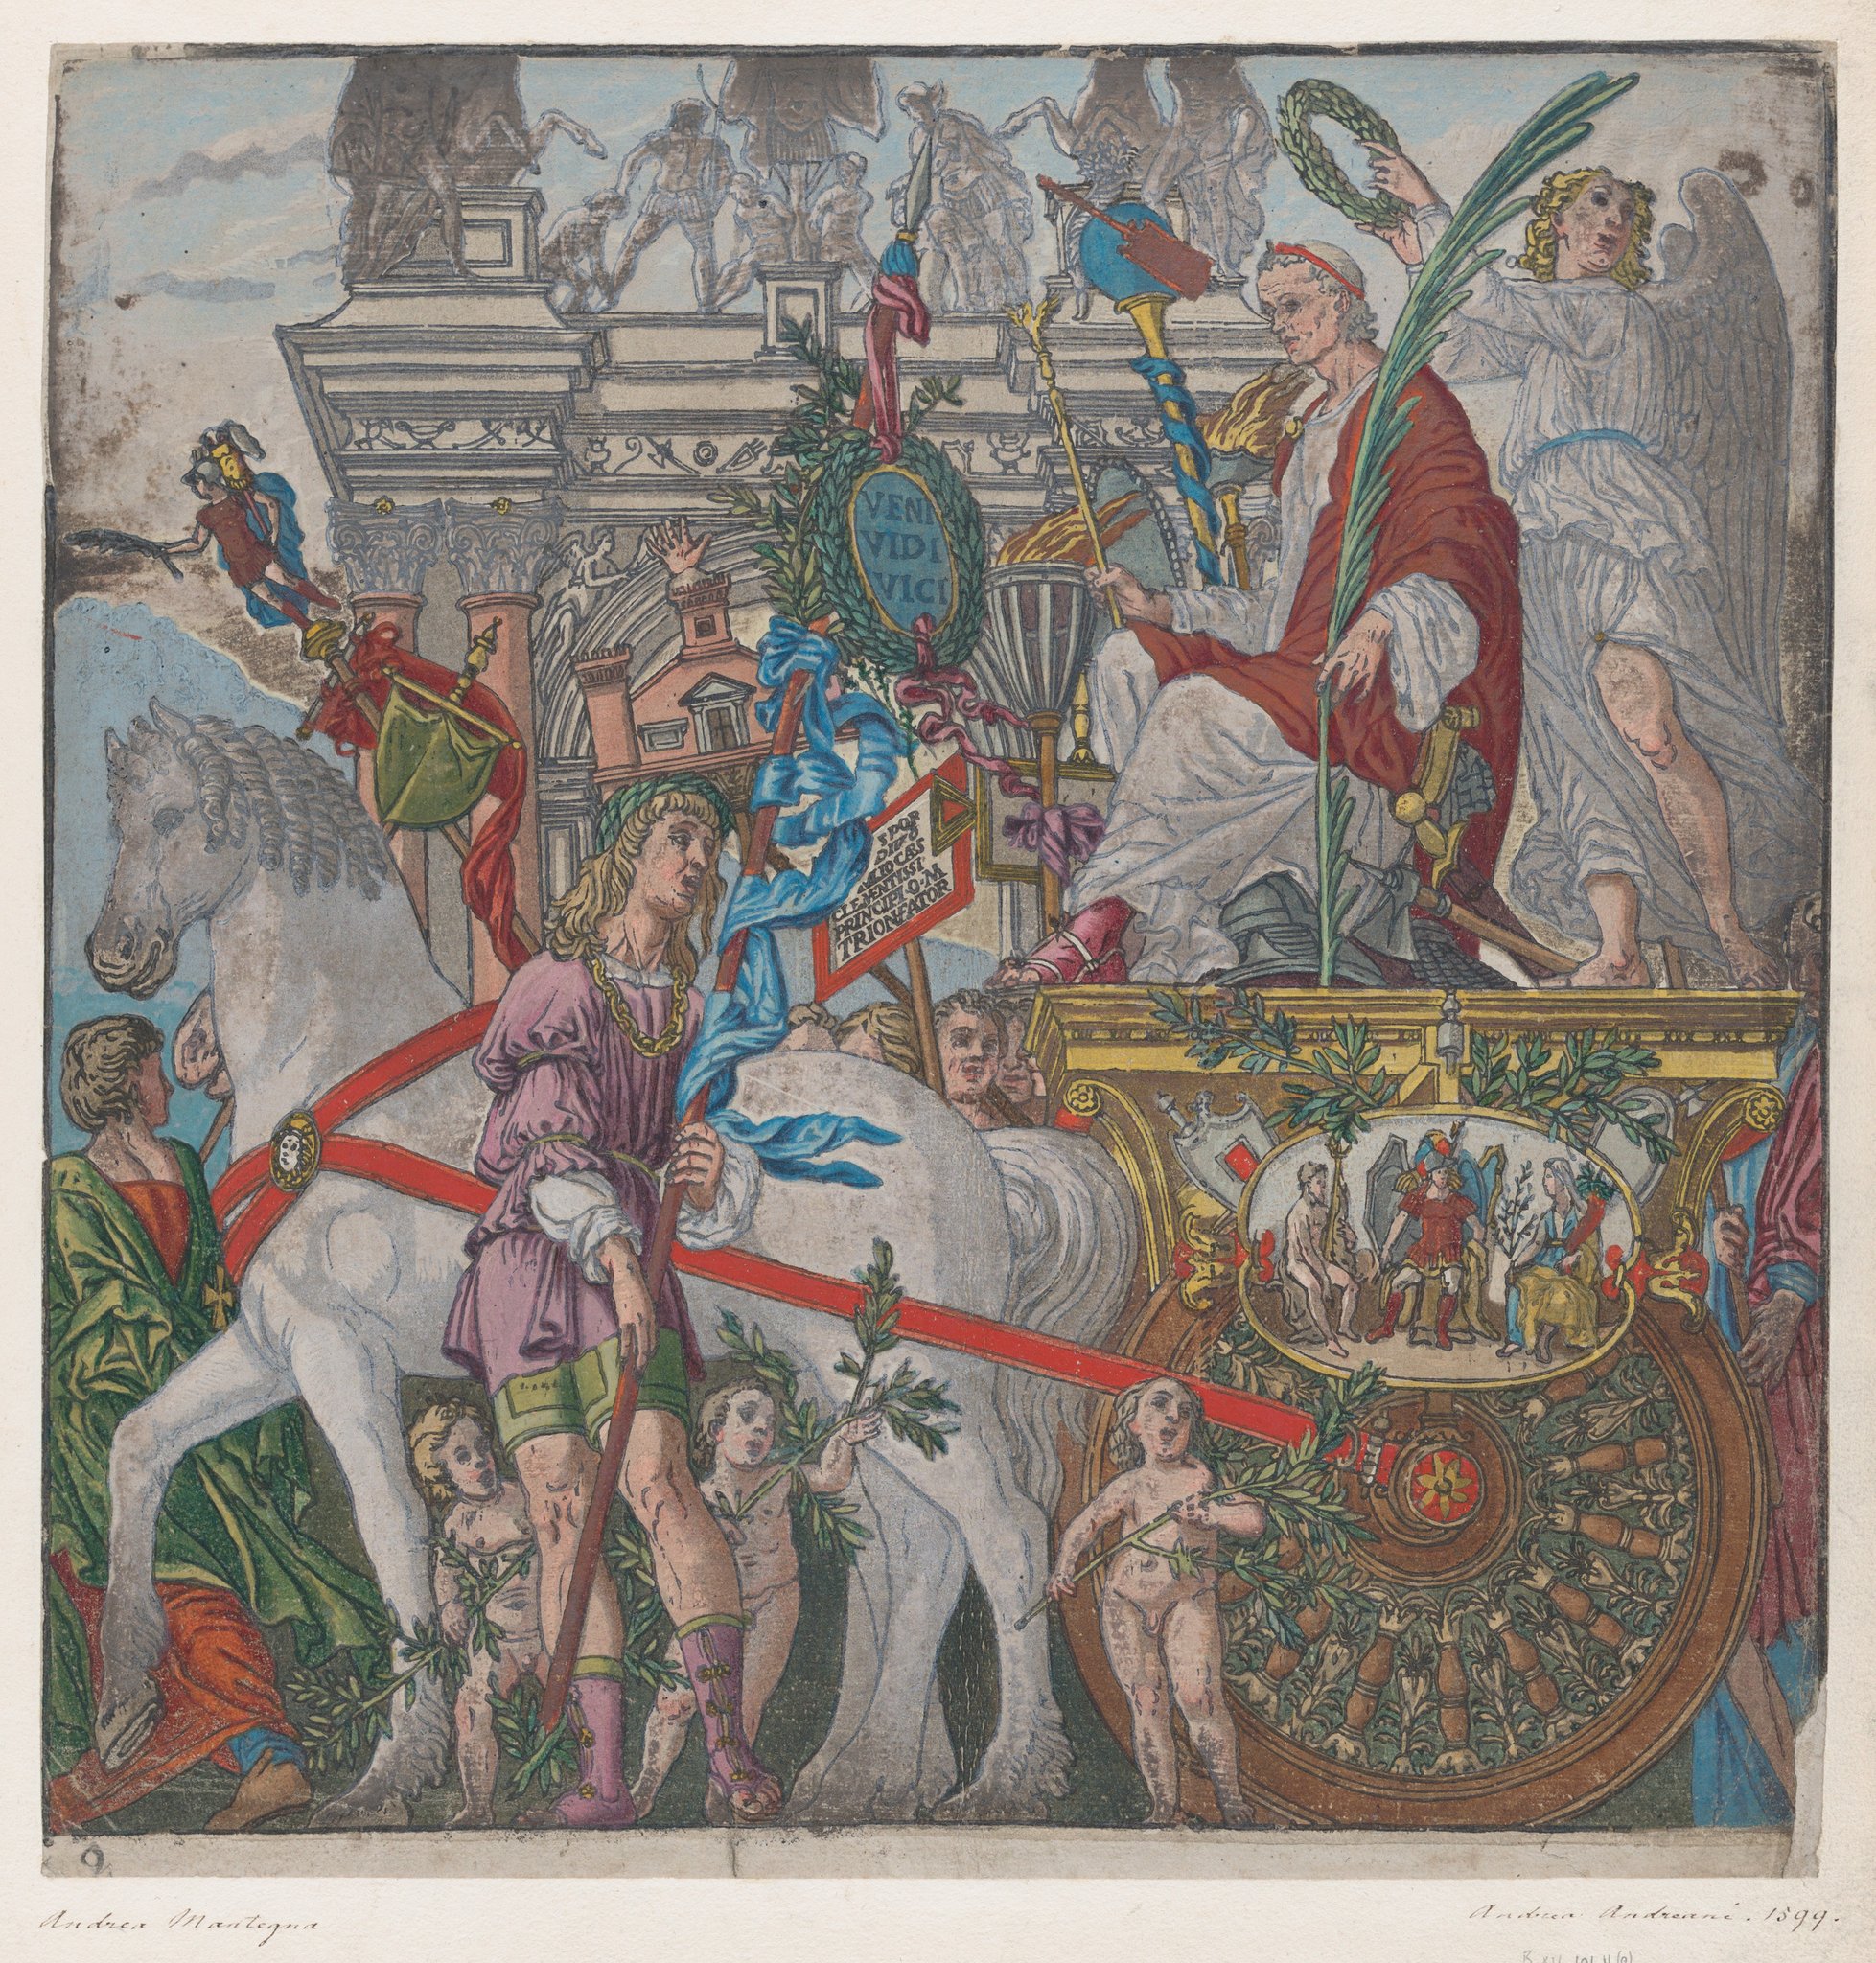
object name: print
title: Sheet 9: Julius Caesar in his horse-drawn chariot, from "The Triumph of Julius Caesar"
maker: andrea andreani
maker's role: artist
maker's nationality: italian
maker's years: 1558-1629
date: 1599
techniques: hand coloring, woodcut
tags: julius caesar,men,horses,chariots